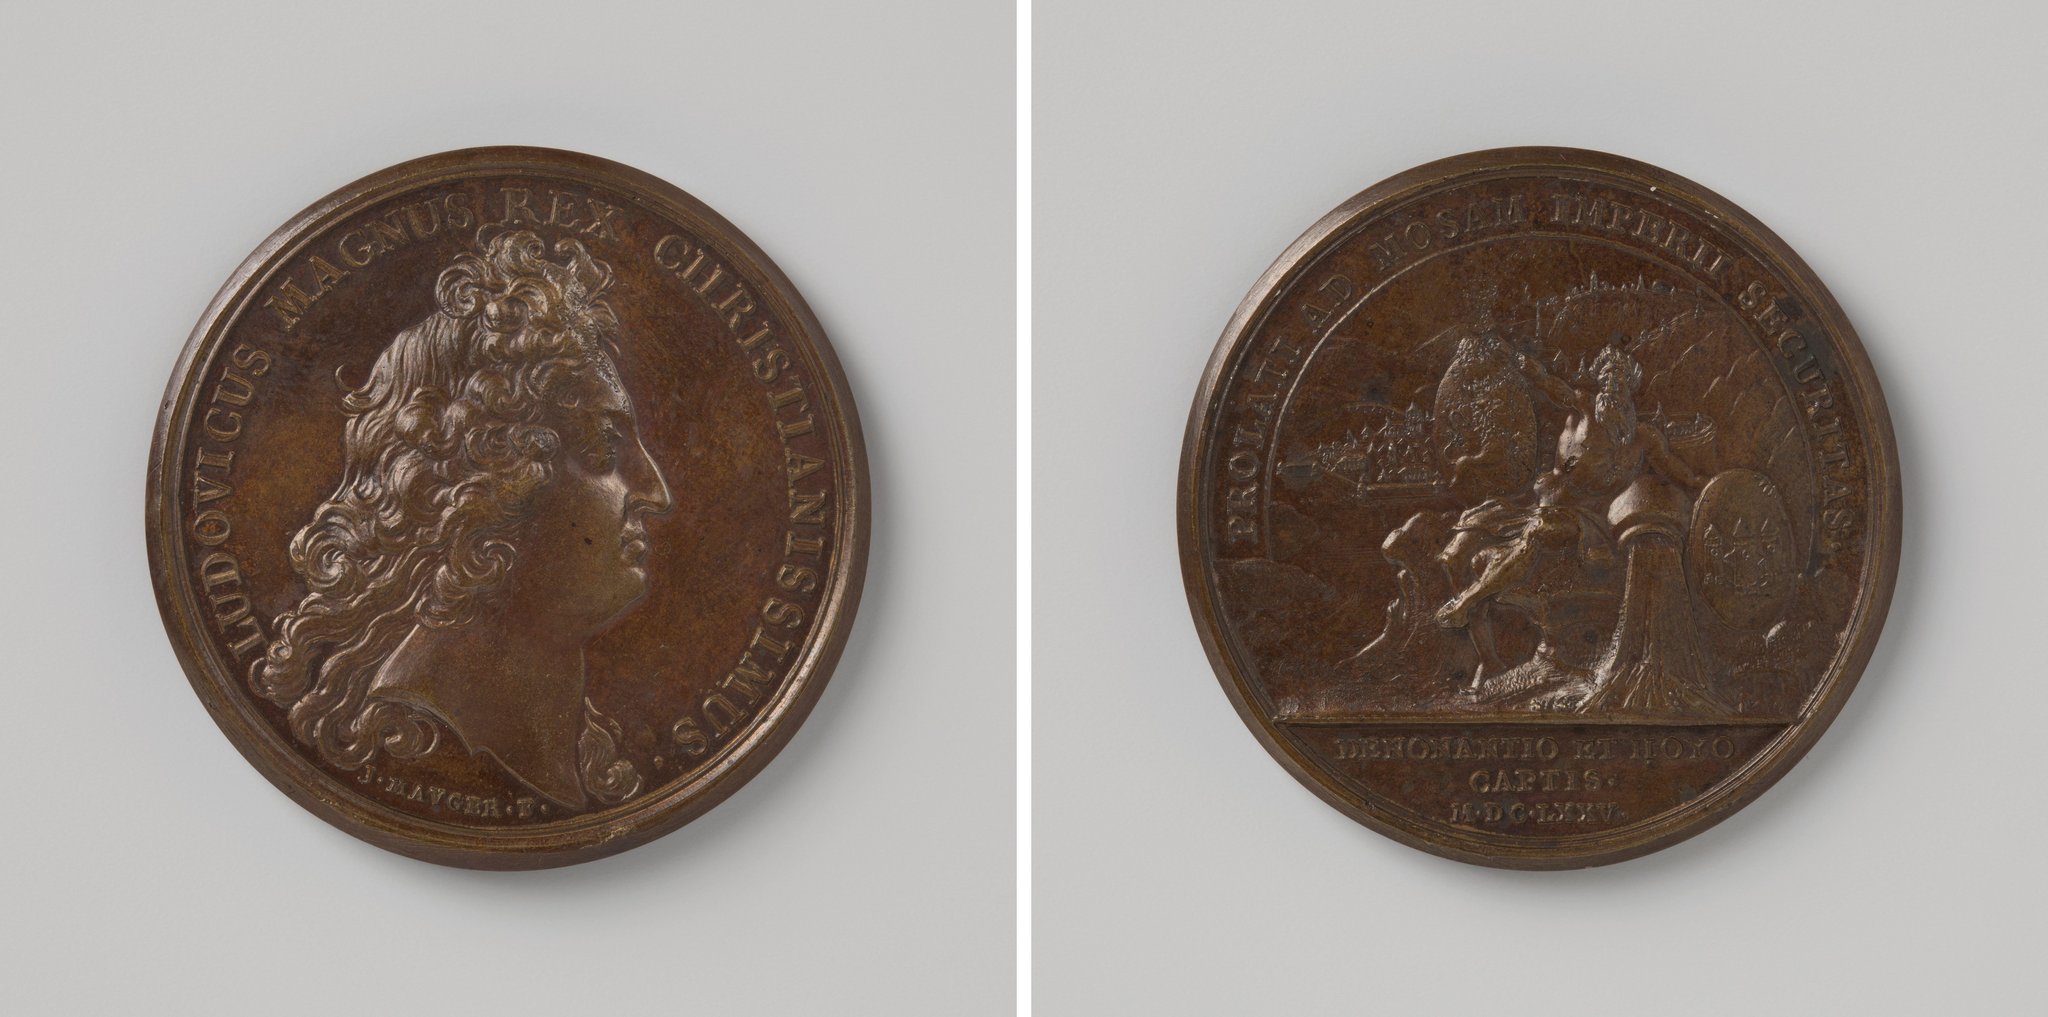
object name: history medal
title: Inname van Dinant en Huy door de Fransen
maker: jean mauger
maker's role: medailleur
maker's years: 1648-1722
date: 1699-1703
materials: bronze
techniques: striking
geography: paris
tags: lodewijk xiv (koning van frankrijk), namur, liège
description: Bronzen penning. Voorzijde: borststuk man binnen omschrift. Keerzijde: Maasgod leunend op zijn waterkruik houdt twee wapenschilden vast; op de achtergrond de beide veroverde steden binnen omschrift.